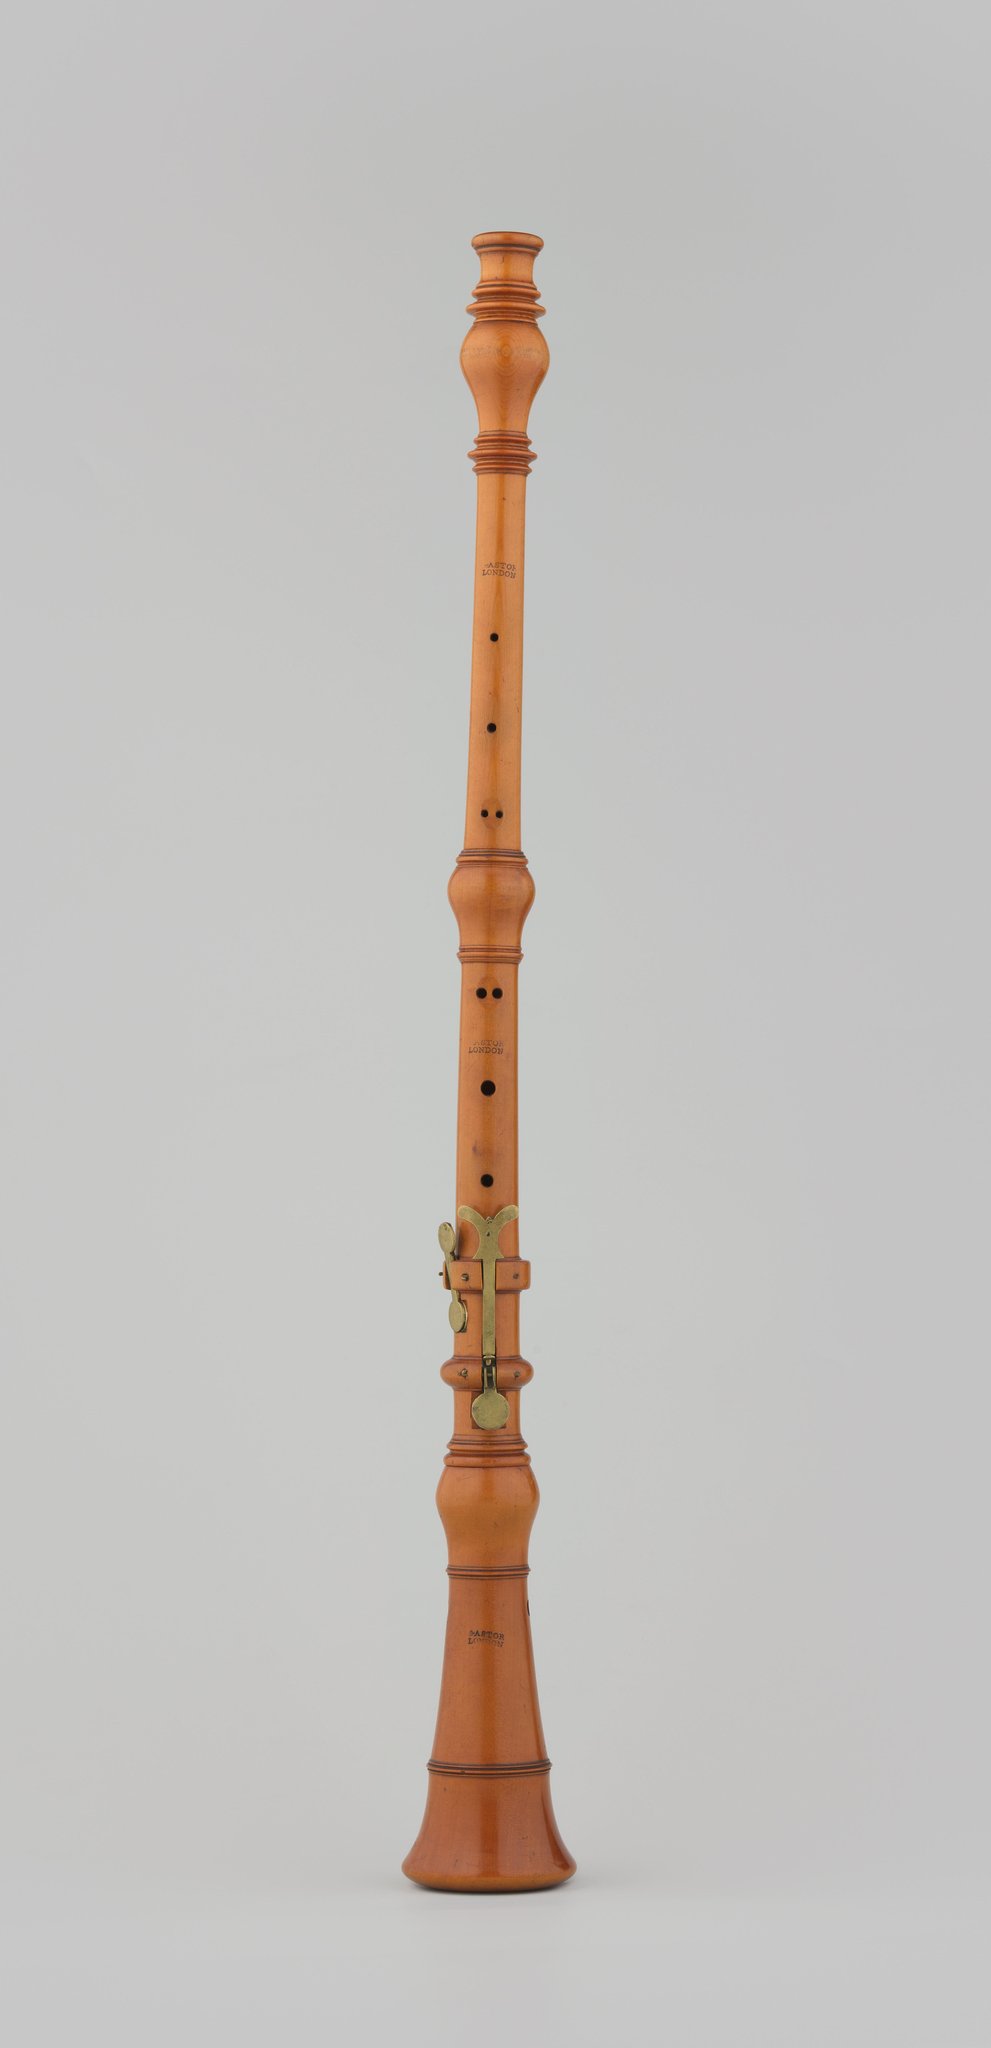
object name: wind instrument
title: Oboe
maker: george astor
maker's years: 1752-1813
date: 1800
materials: wood, brass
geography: london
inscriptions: inscription: ‘G. ASTOR / LONDON.’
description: Hobo van palmhout met twee ronde messing kleppen. Het derde en het vierde gat zijn dubbel. Gemarkeerd op alle drie de delen: G. ASTOR / LONDON.